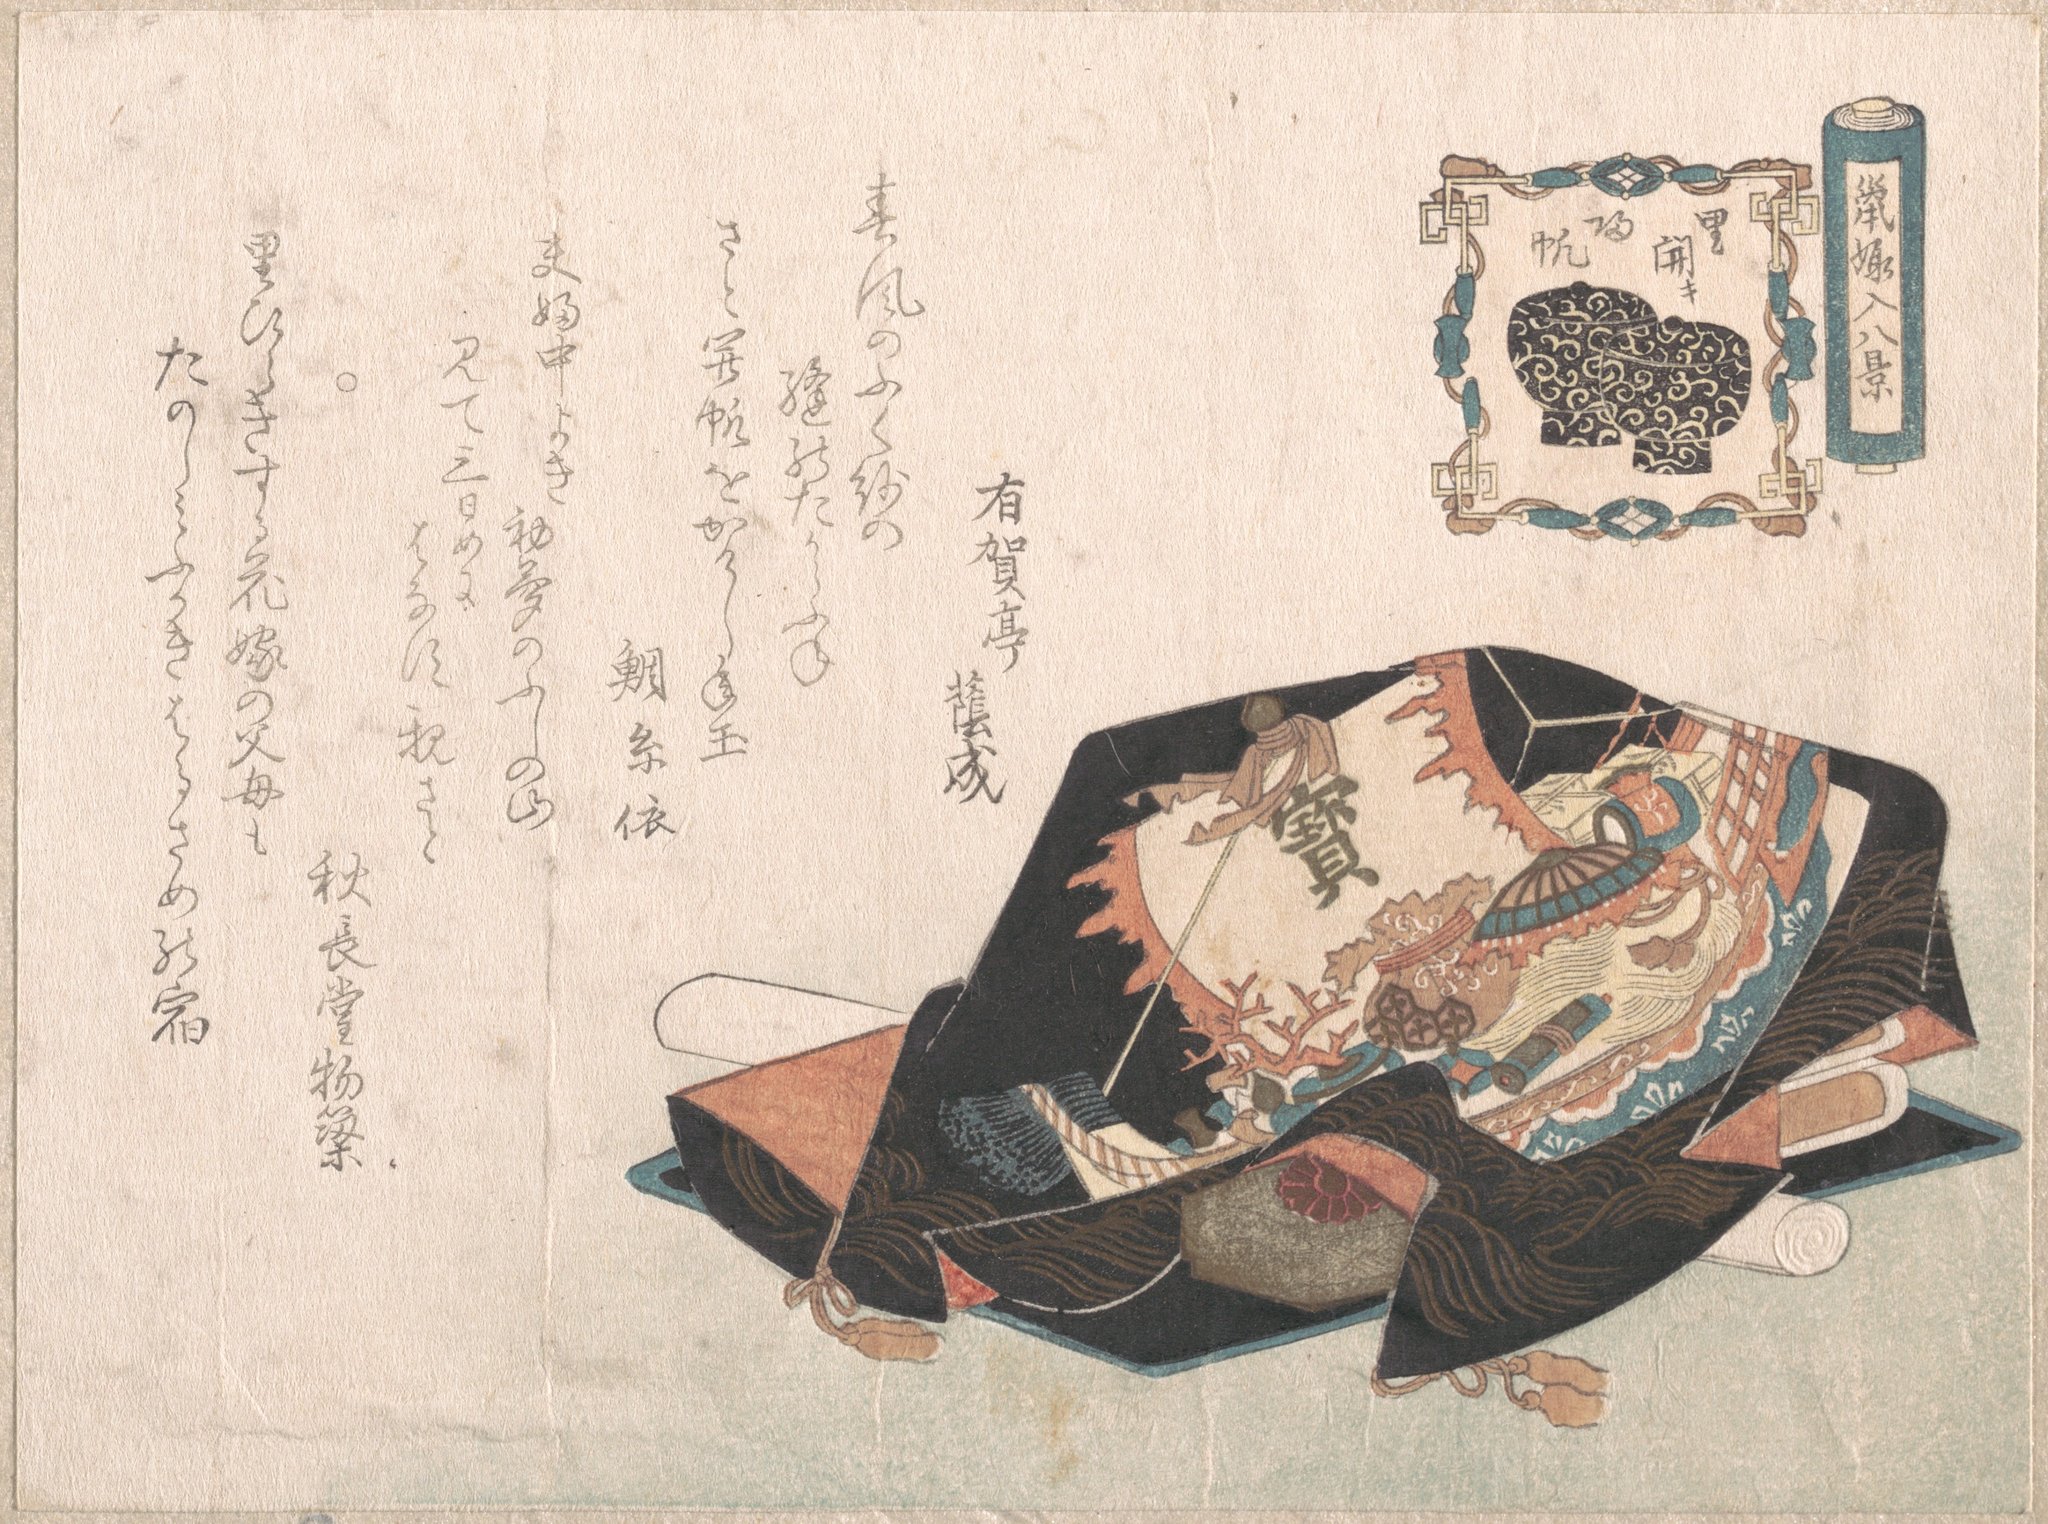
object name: woodblock print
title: Souvenirs Covered with Wrapping Cloth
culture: japanese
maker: unidentified artist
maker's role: artist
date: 1816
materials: ink, paper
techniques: surimono, woodblock print